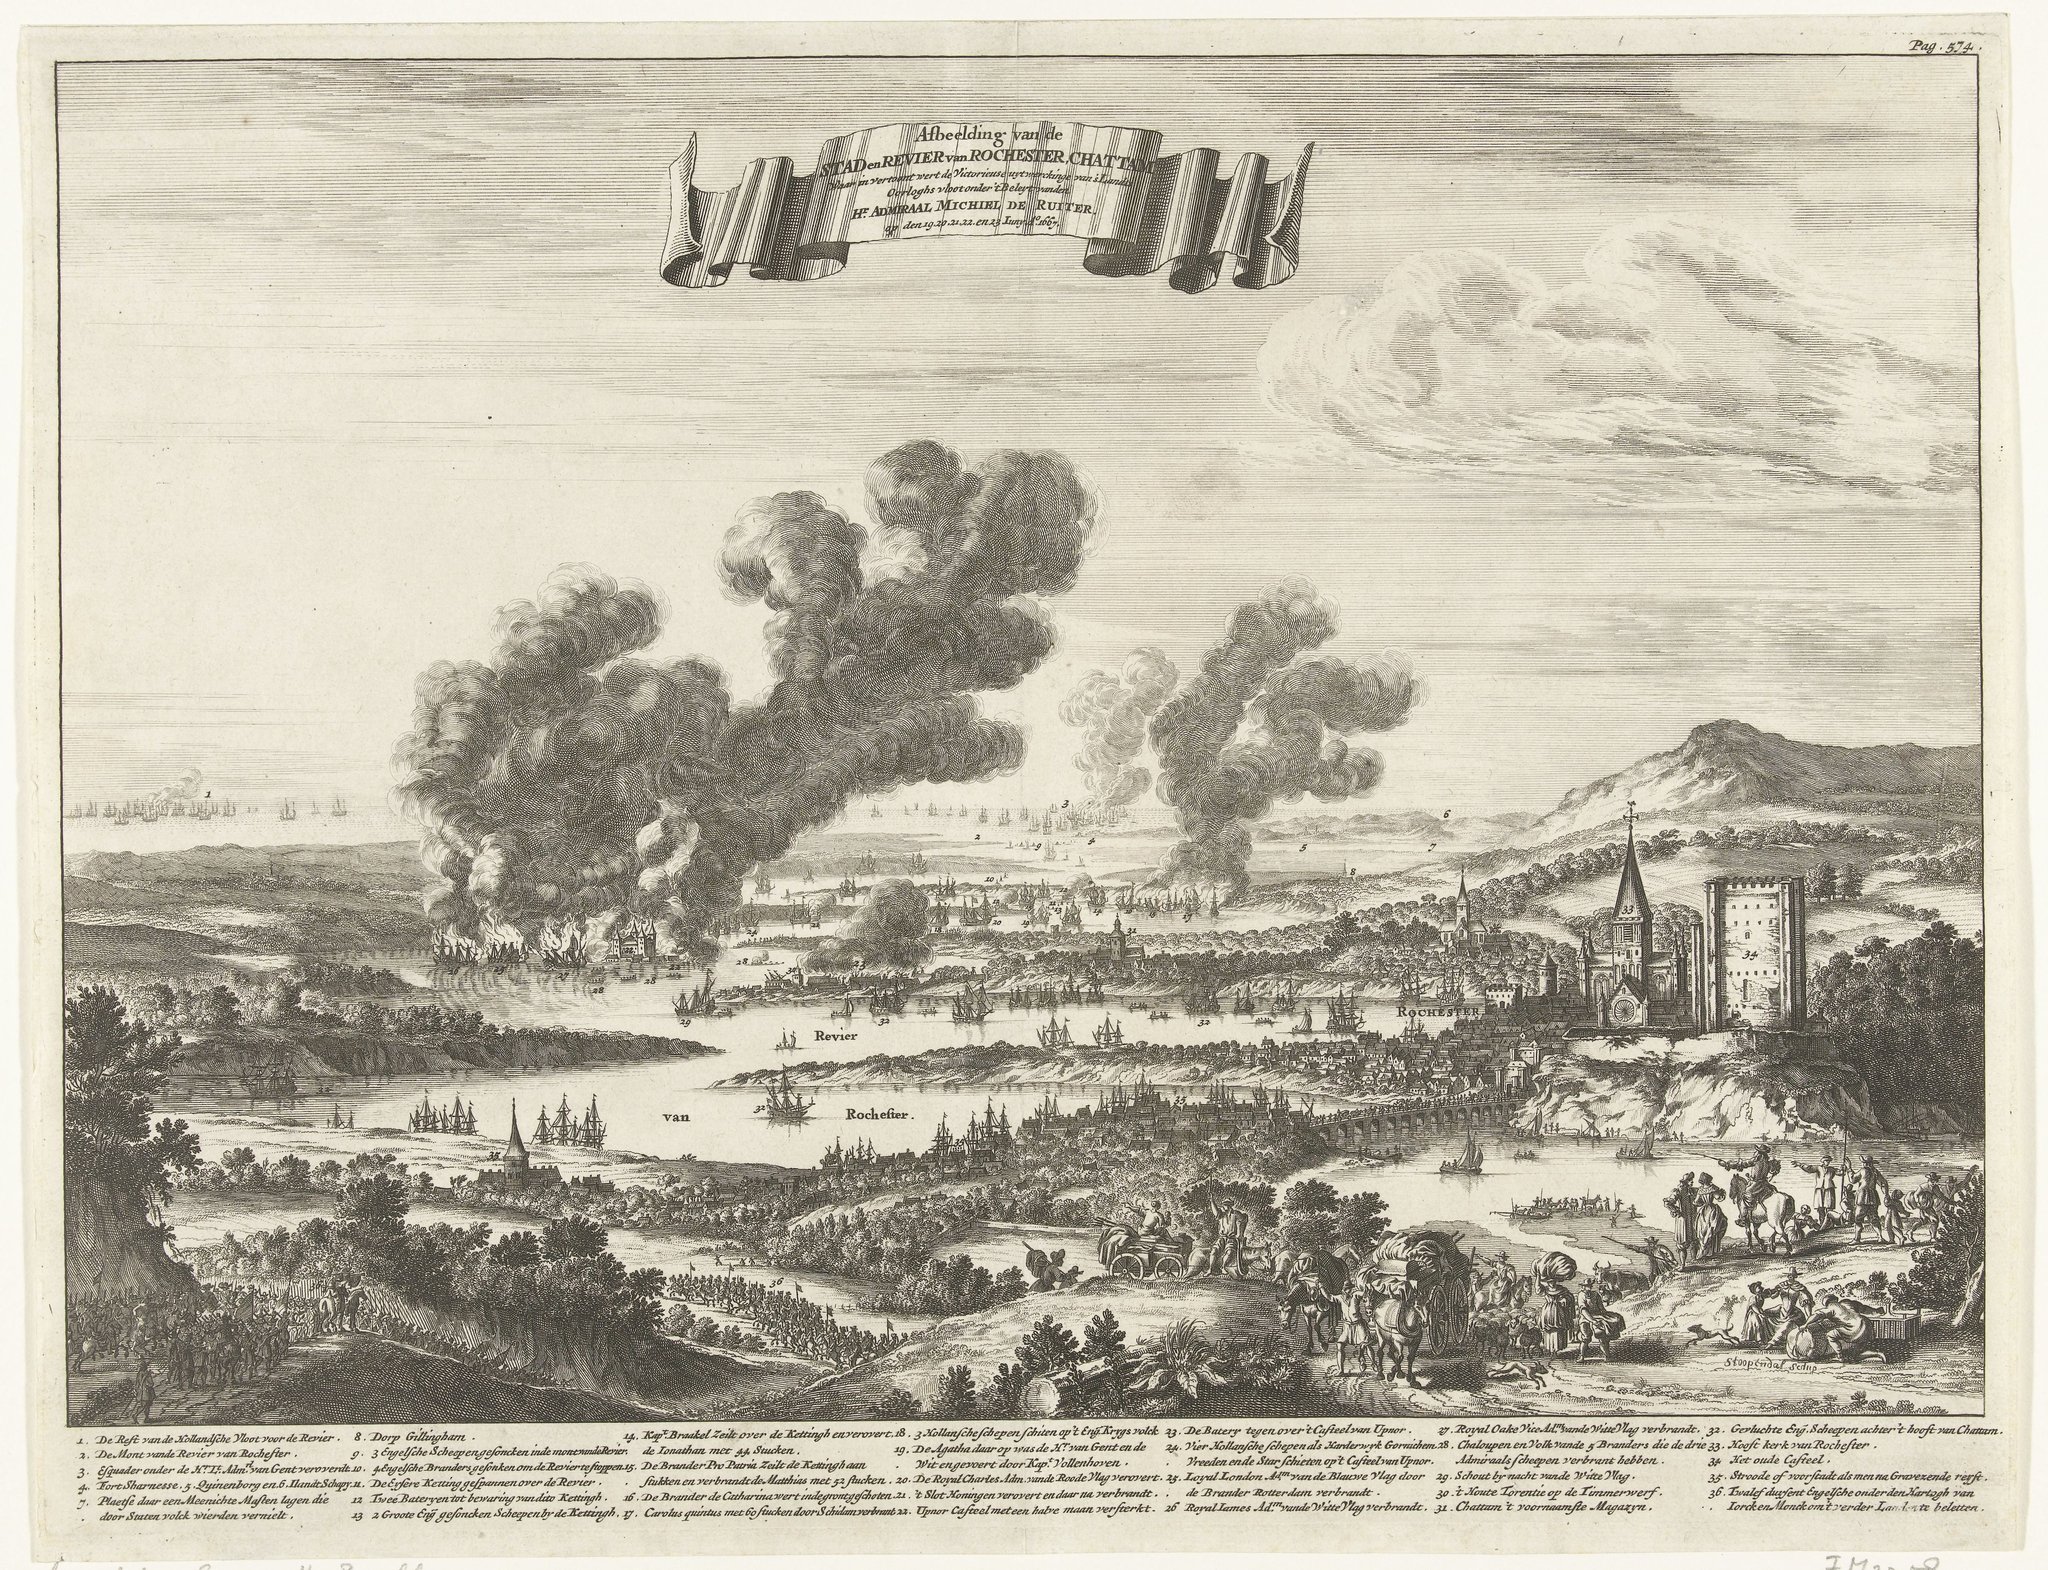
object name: print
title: The Dutch Raid on the Medway, 1667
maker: bastiaen stopendael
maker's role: print maker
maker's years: 1636-1693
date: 1685-1687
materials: paper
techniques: etching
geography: northern netherlands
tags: flushing, michiel adriaenszoon de ruyter, battle (+ naval force), raid on the medway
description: Landschappelijke voorstelling van de Tocht naar Chatham en de vernietiging van de Engelse vloot op 20 juni 1667 door de Staatse vloot onder Michiel Adriaenszoon de Ruyter. In het onderschrift de legenda 1-36 in het Nederlands. Gemerkt rechtsboven: Pag. 574.